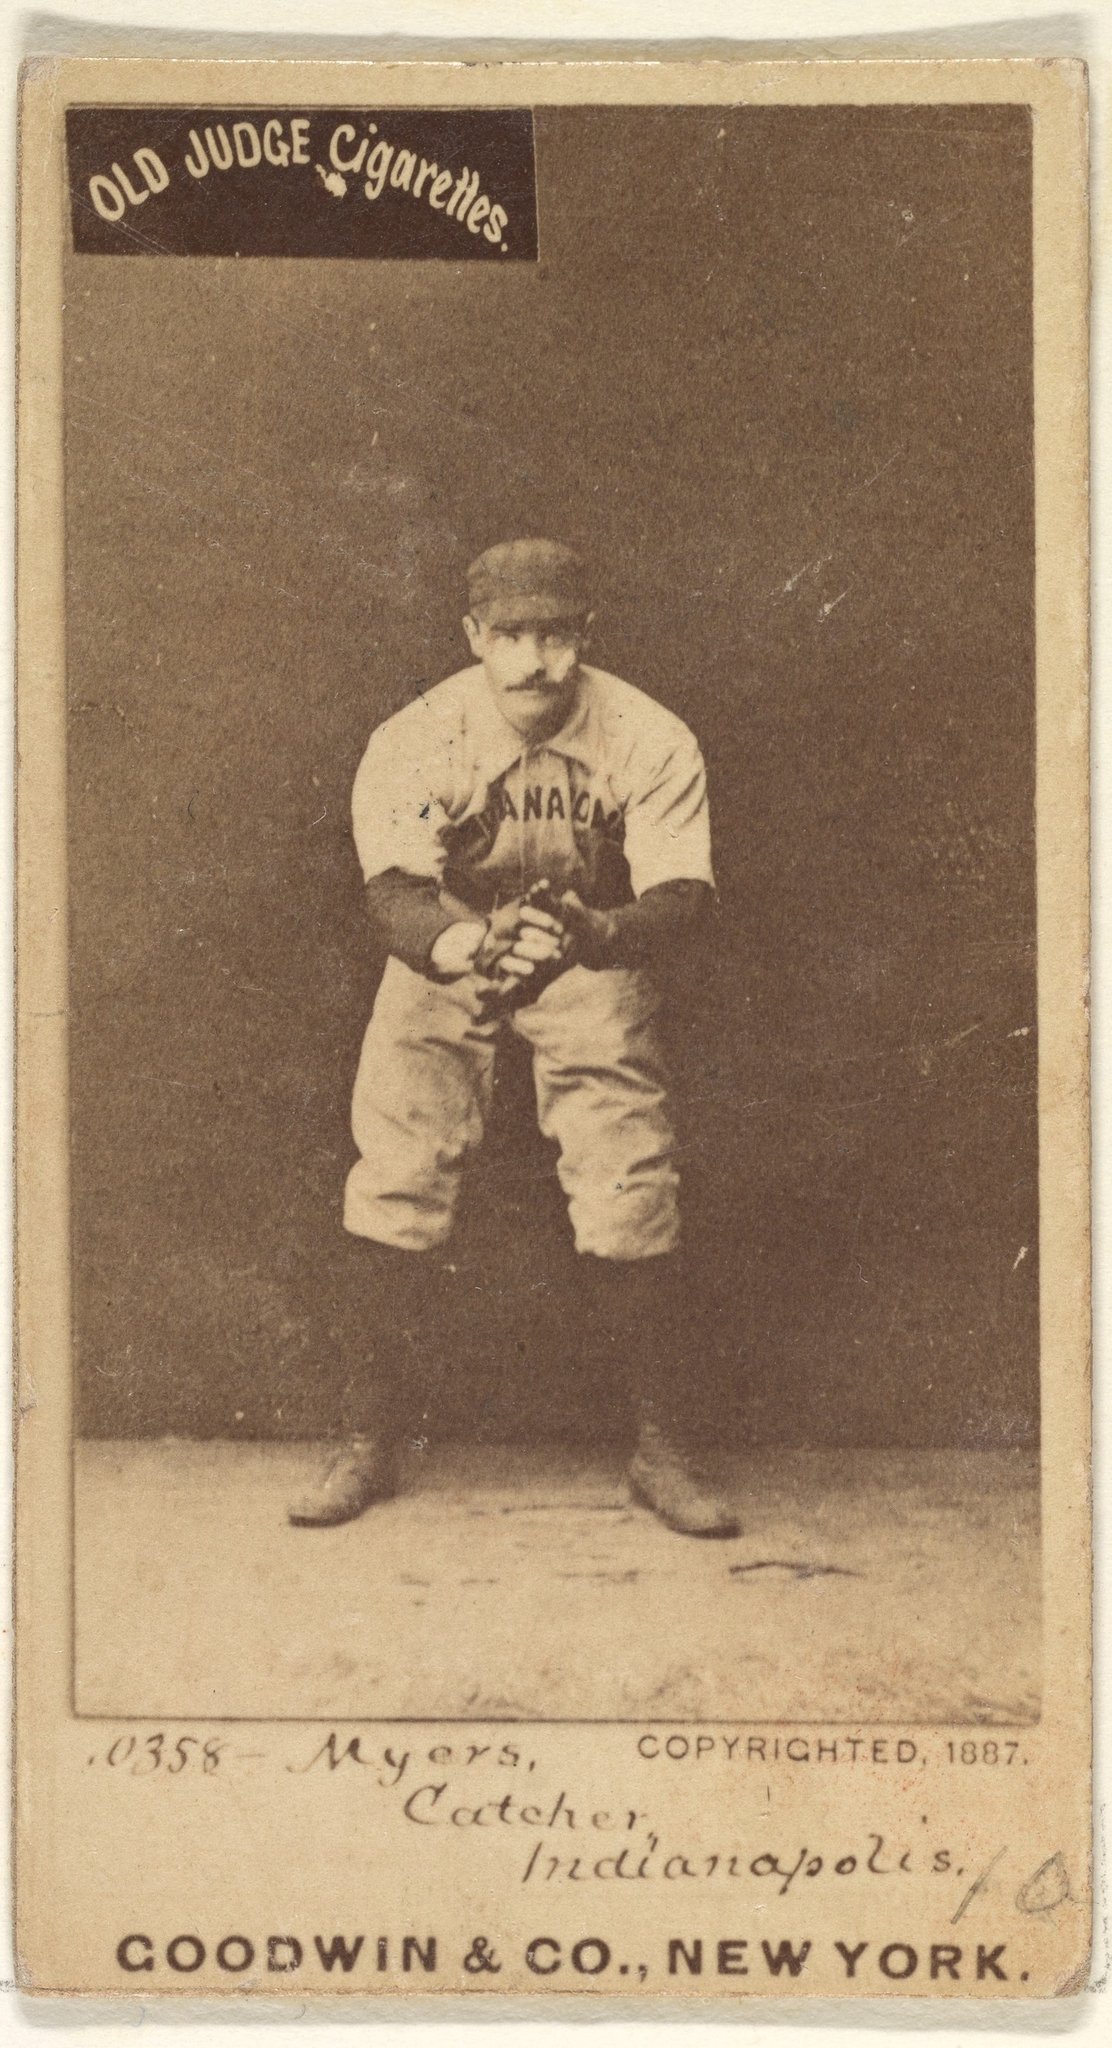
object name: baseball card, photograph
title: Myers, Catcher, Indianapolis, from the Old Judge series (N172) for Old Judge Cigarettes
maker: goodwin & company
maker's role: publisher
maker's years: 1850-1950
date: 1887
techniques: albumen silver print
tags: men,portraits,baseball,athletes